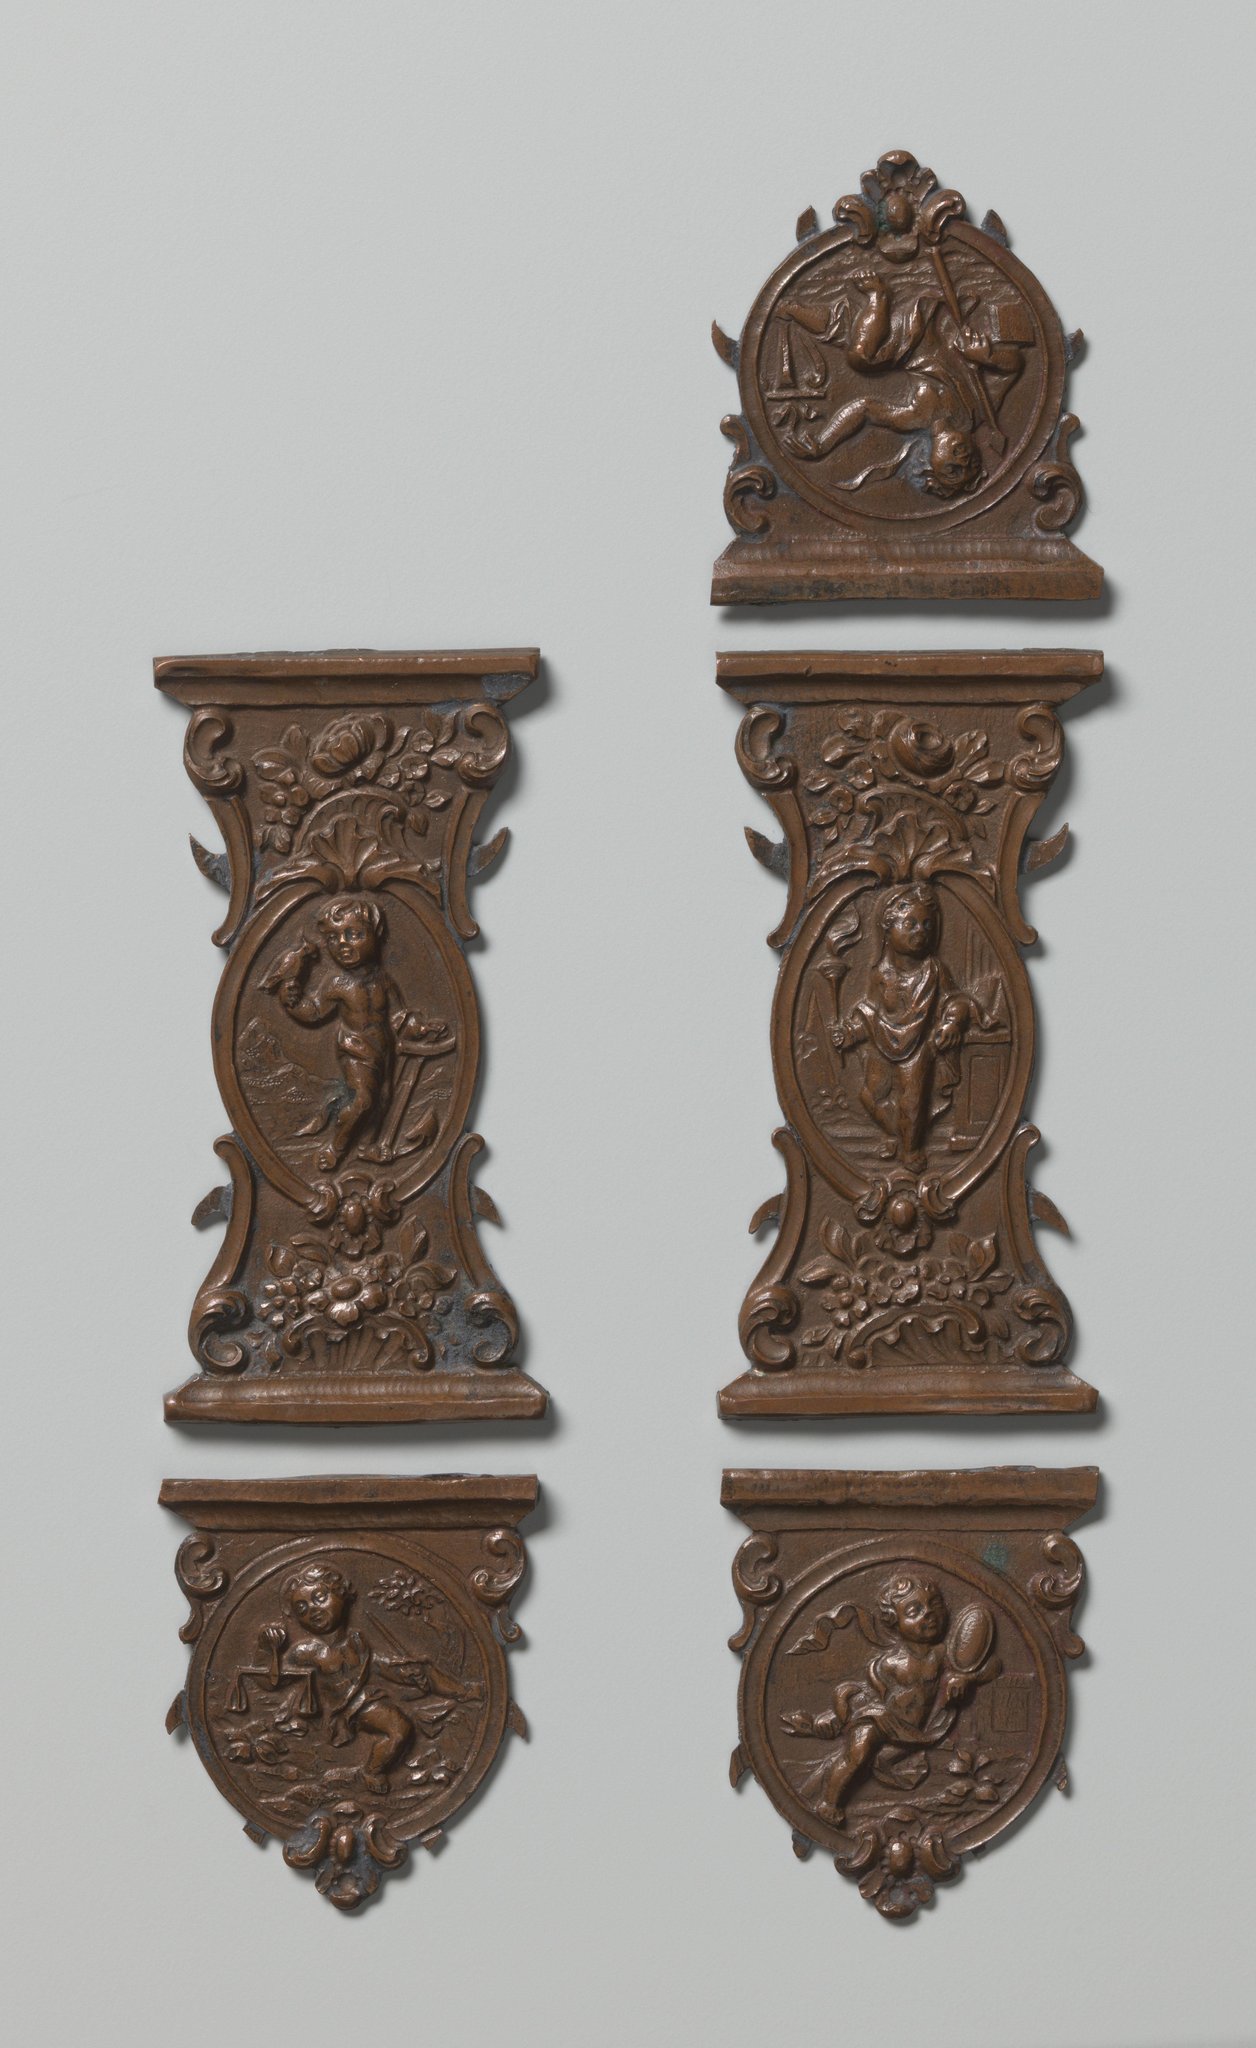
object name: hasp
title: Modellen voor klampen en beugels van boeksloten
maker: Anonymous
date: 1750-1775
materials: copper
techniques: repoussé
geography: amsterdam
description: Modellen voor gietvormen van klampen en beugels van boeksloten. Allen versierd met een in rococo-ornament gevatte voorstelling. De klampen geven respectievelijk een putto met een weegschaal en een zwaard; een putto met een lans en een brandend altaar en een putto met een spiegel weer. De beugels geven een putto met een brandende fakkel en een putto met een anker en een vogel weer. De achterzijden zijn met pek opgevuld.